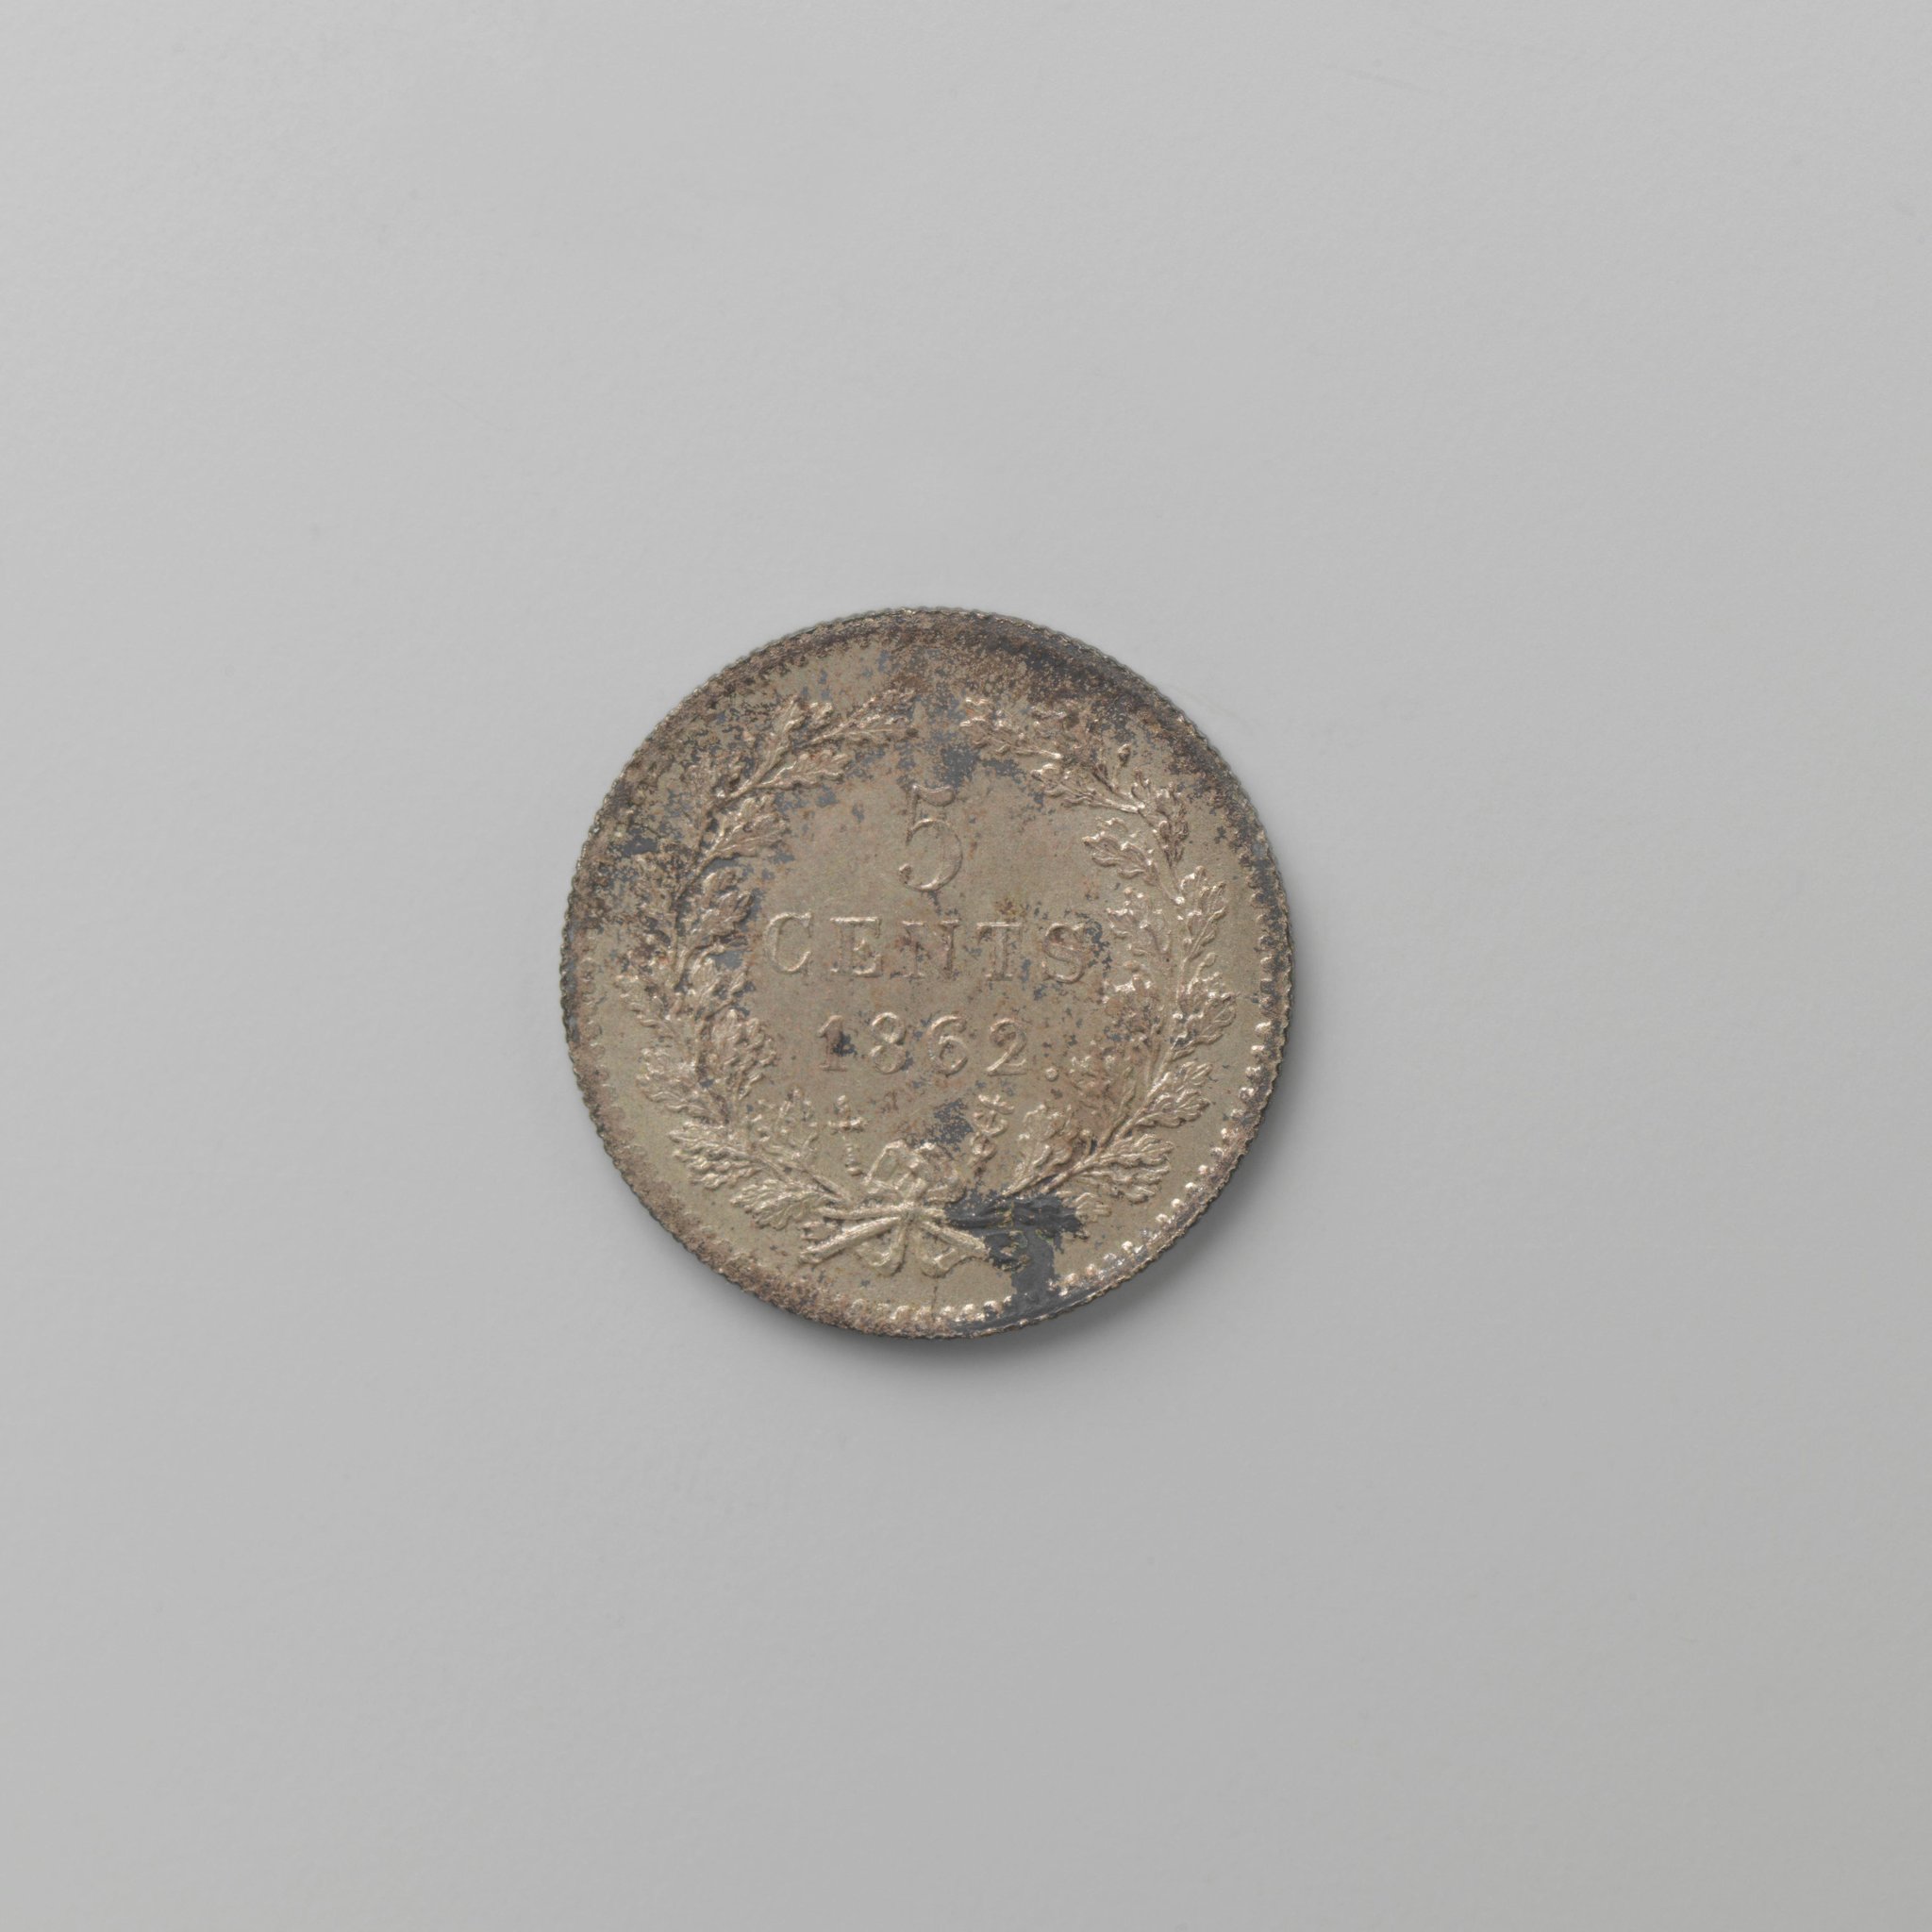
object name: coin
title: Nederlandse 5 cent, 1862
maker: willem iii (koning der nederlanden)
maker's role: koning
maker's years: 1817-1890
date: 1862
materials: silver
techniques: striking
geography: utrecht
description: Zilveren munt. Voorzijde: borstbeeld naar rechts. Keerzijde: binnen twee samengebonden eiketakken waarde-aanduiding 5 cents. Daaronder jaartal. Kartelrand.